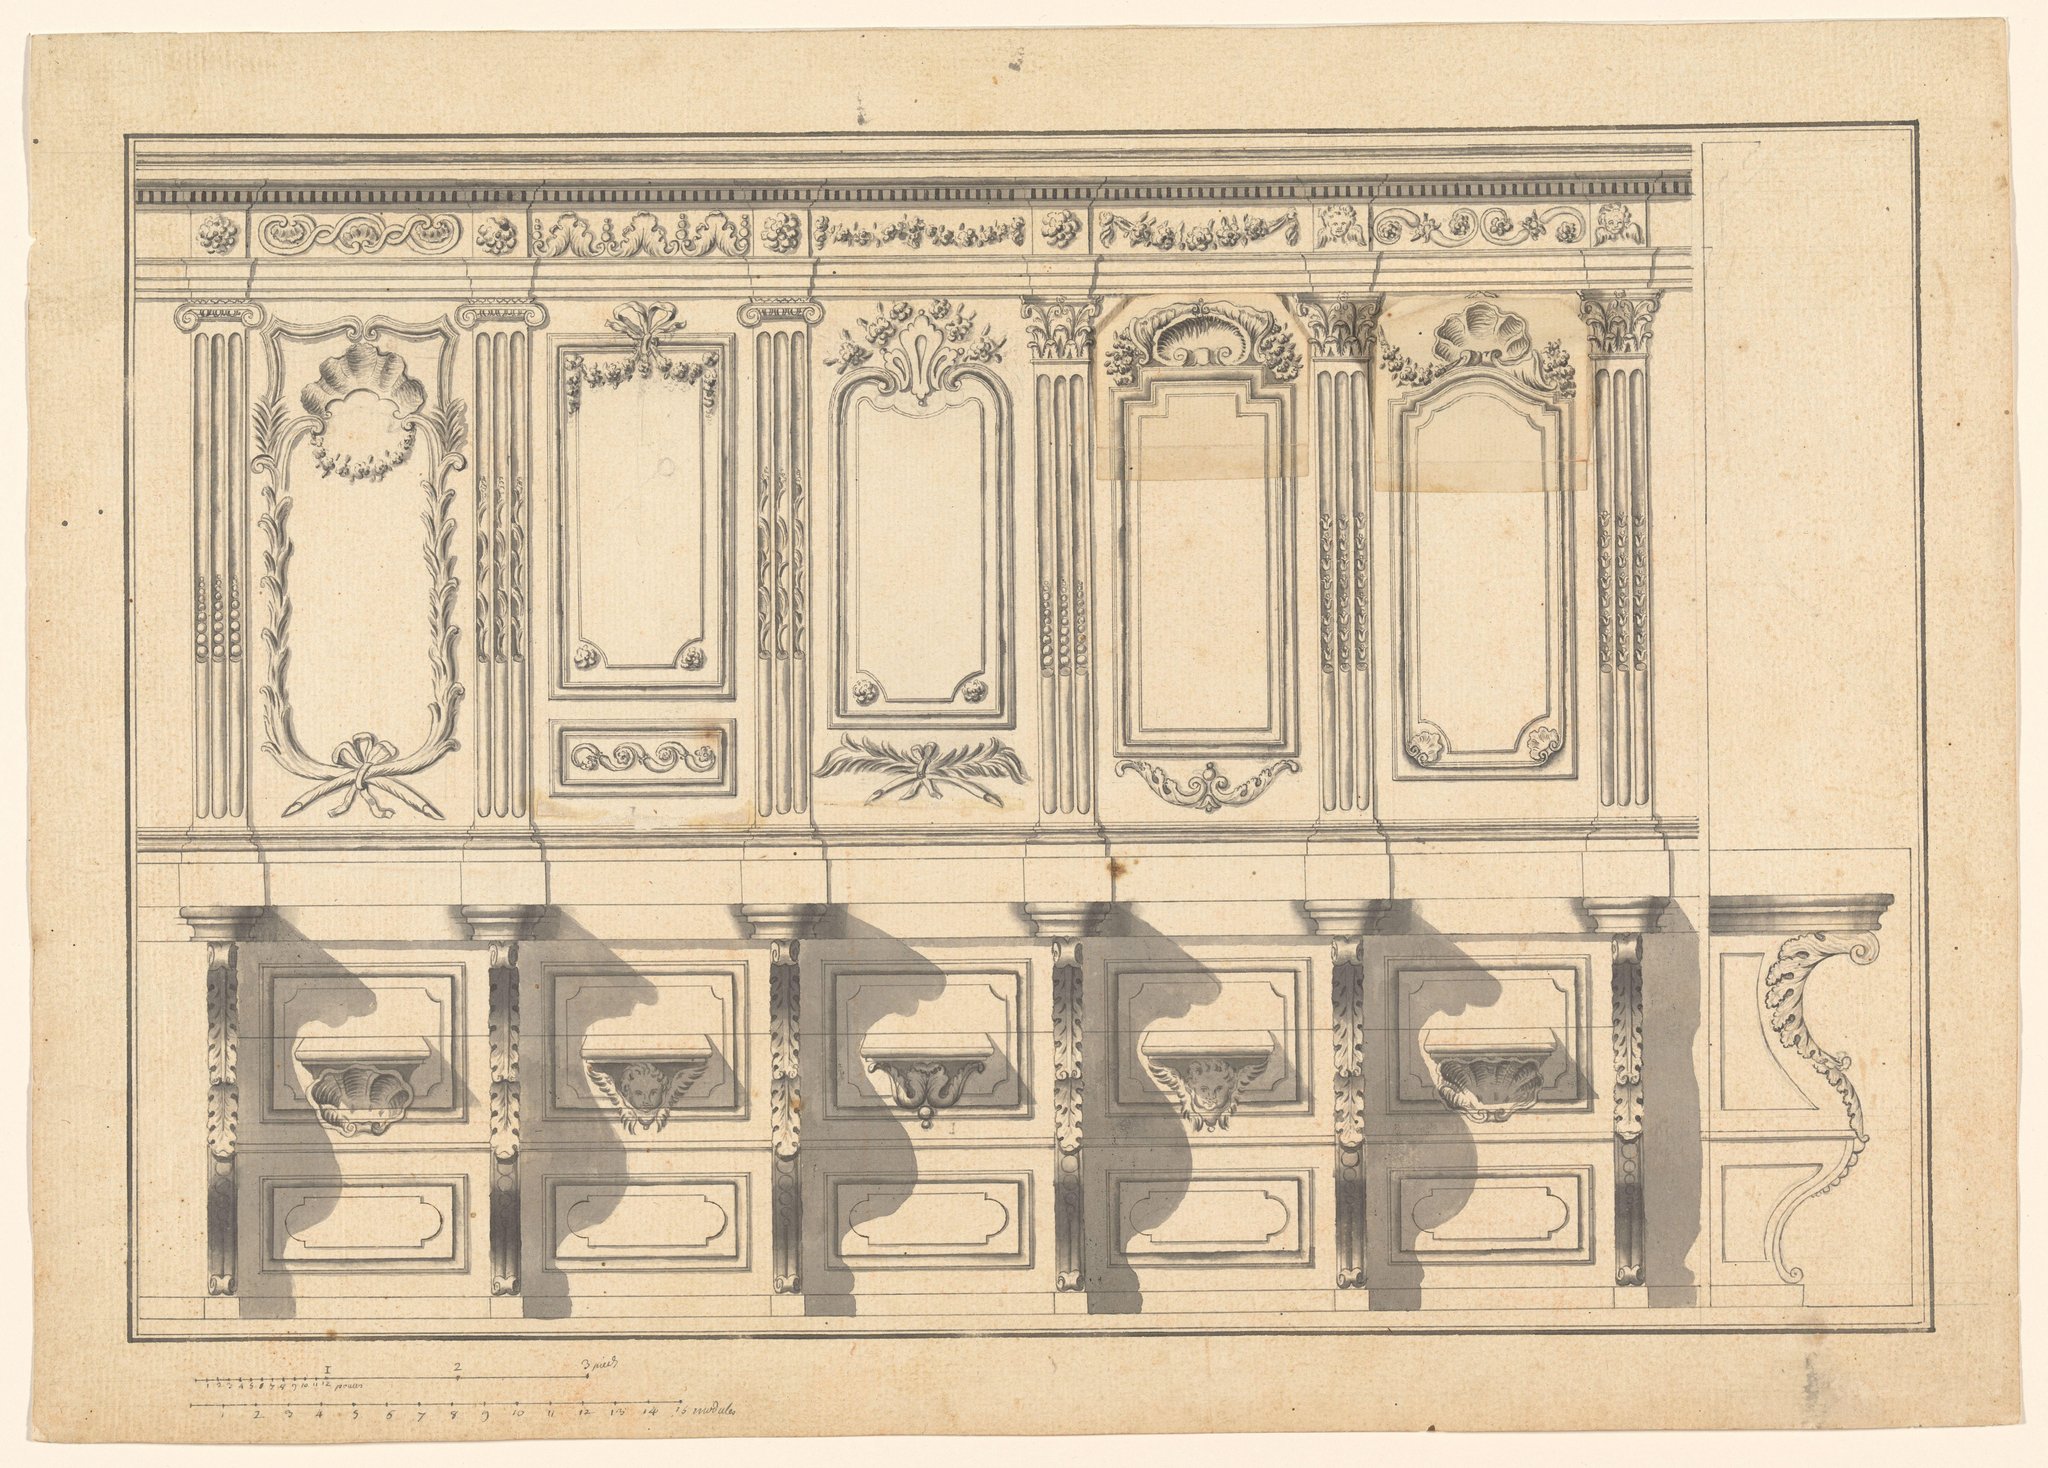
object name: drawing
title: Ontwerp voor een koorgestoelte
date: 1769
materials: graphite, paper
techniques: brush, pen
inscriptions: watermark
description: Ontwerp voor een koorgestoelte met vijf alternatieve oplossingen voor de versiering van de banken, en twee opgeplakte alternatieven voor bekroningen. Met maatverdeling.